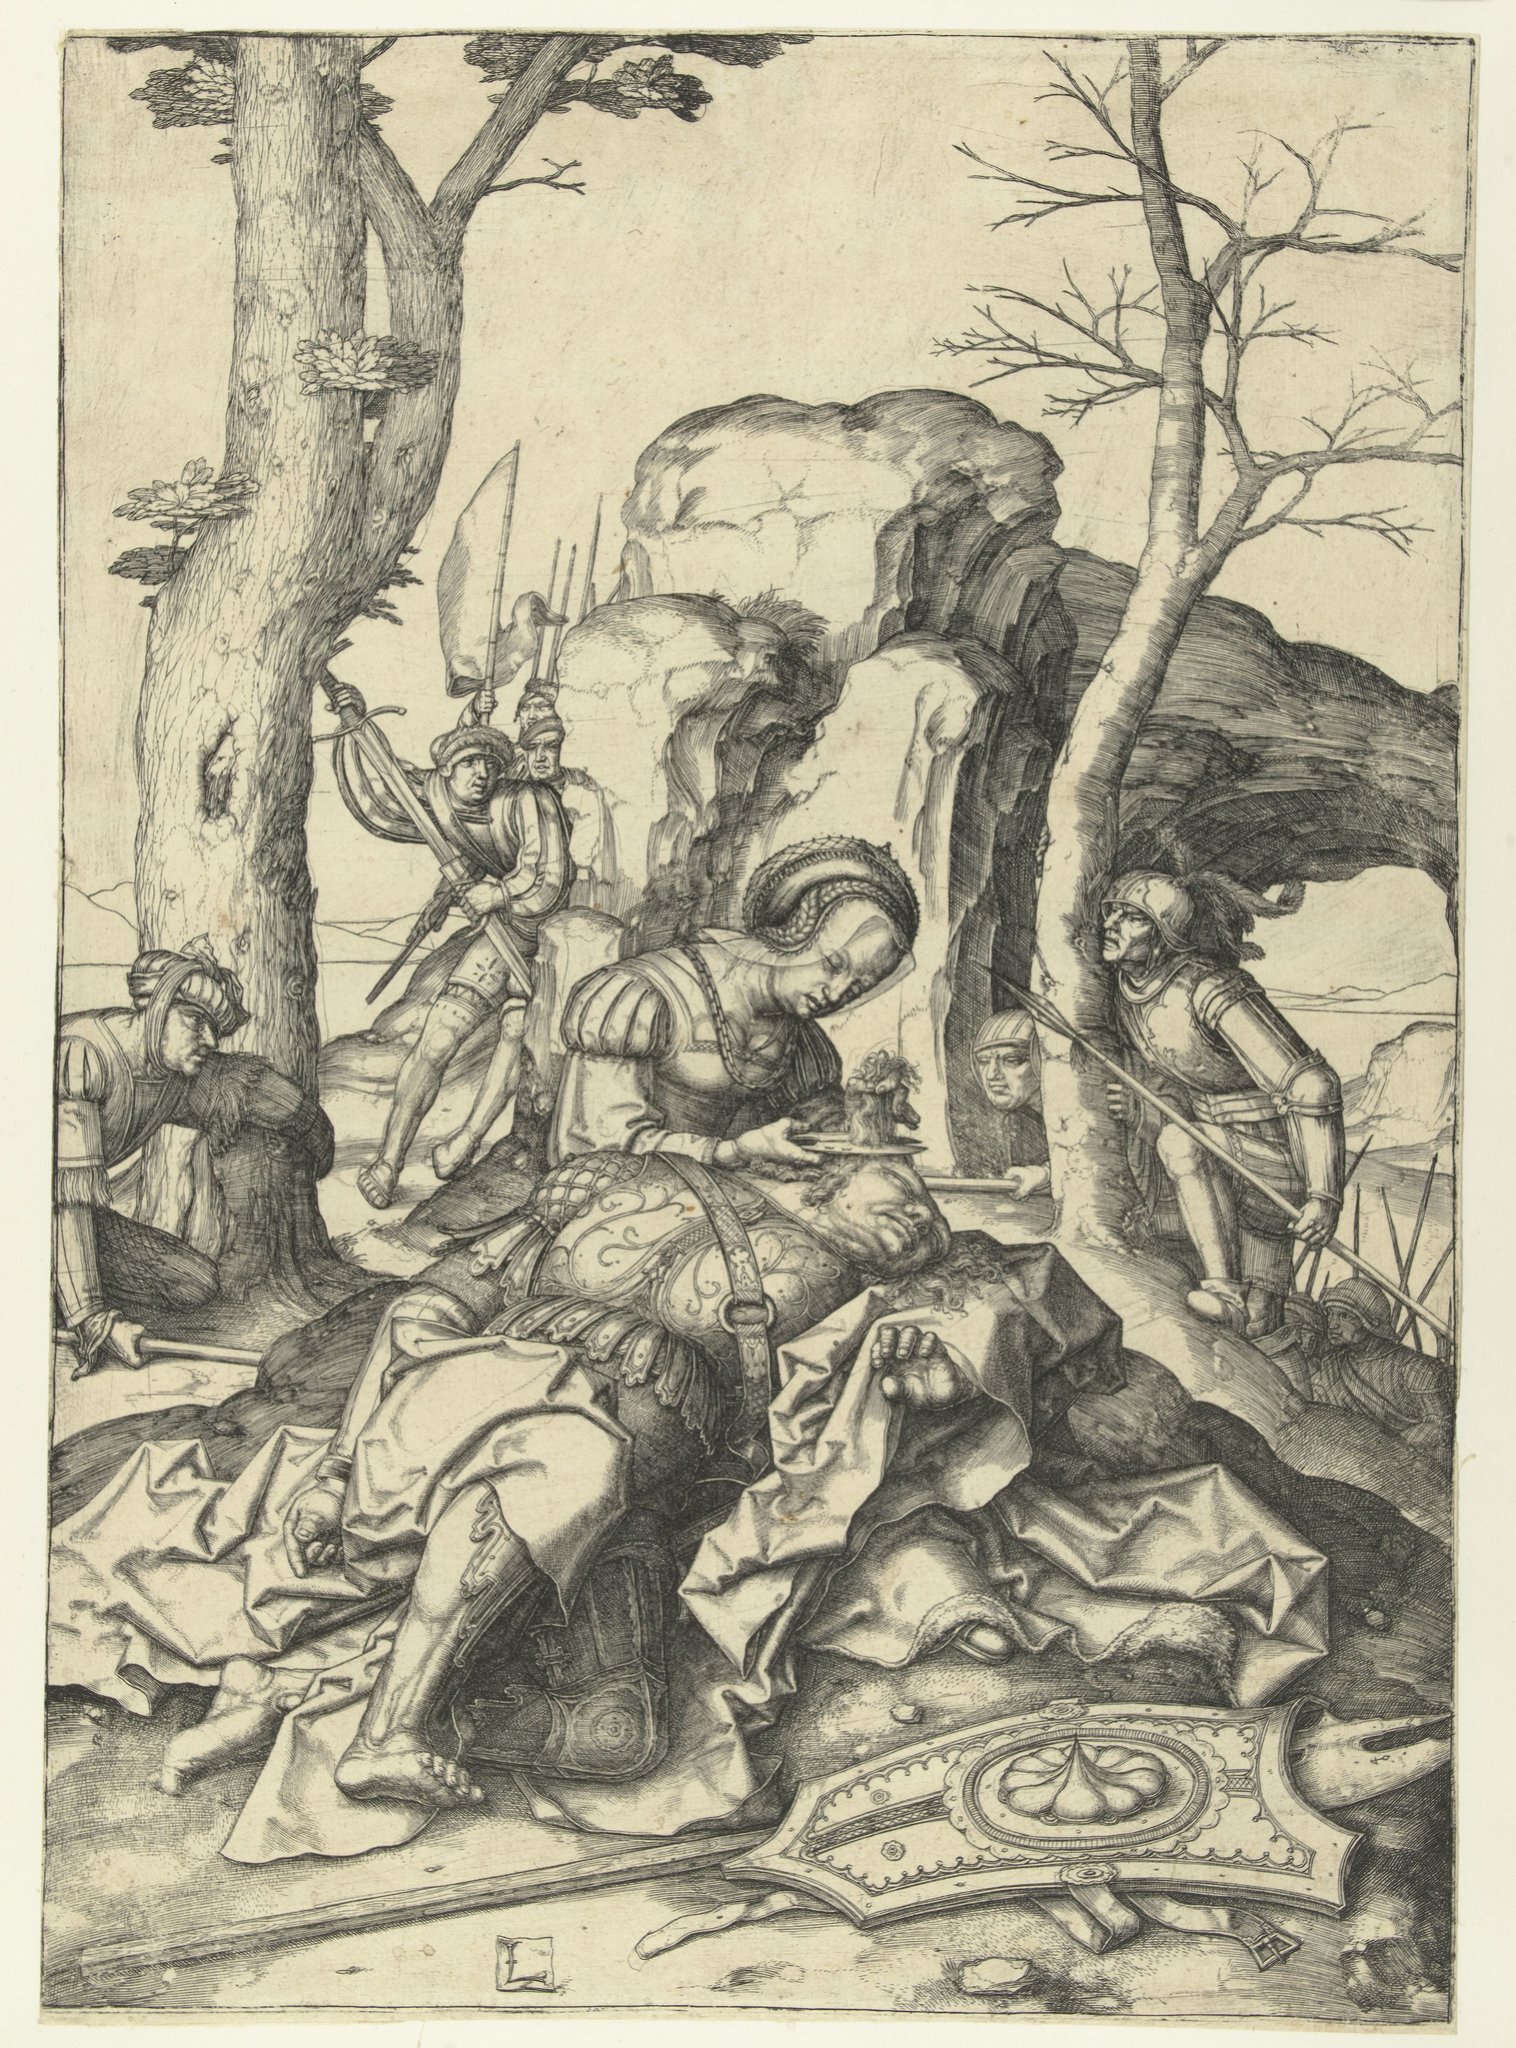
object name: print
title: Simson en Delila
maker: lucas van leyden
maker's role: draughtsman, painter, print maker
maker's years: 1494-1533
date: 1505-1509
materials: paper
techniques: engraving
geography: low countries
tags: samson's hairlocks are cut off by delilah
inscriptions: collector's mark: Lugt 240, signature: ‘L’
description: Delila knipt het haar af van Simson slapend op haar schoot. Aantal gewapende mannen staat klaar om aan te vallen.